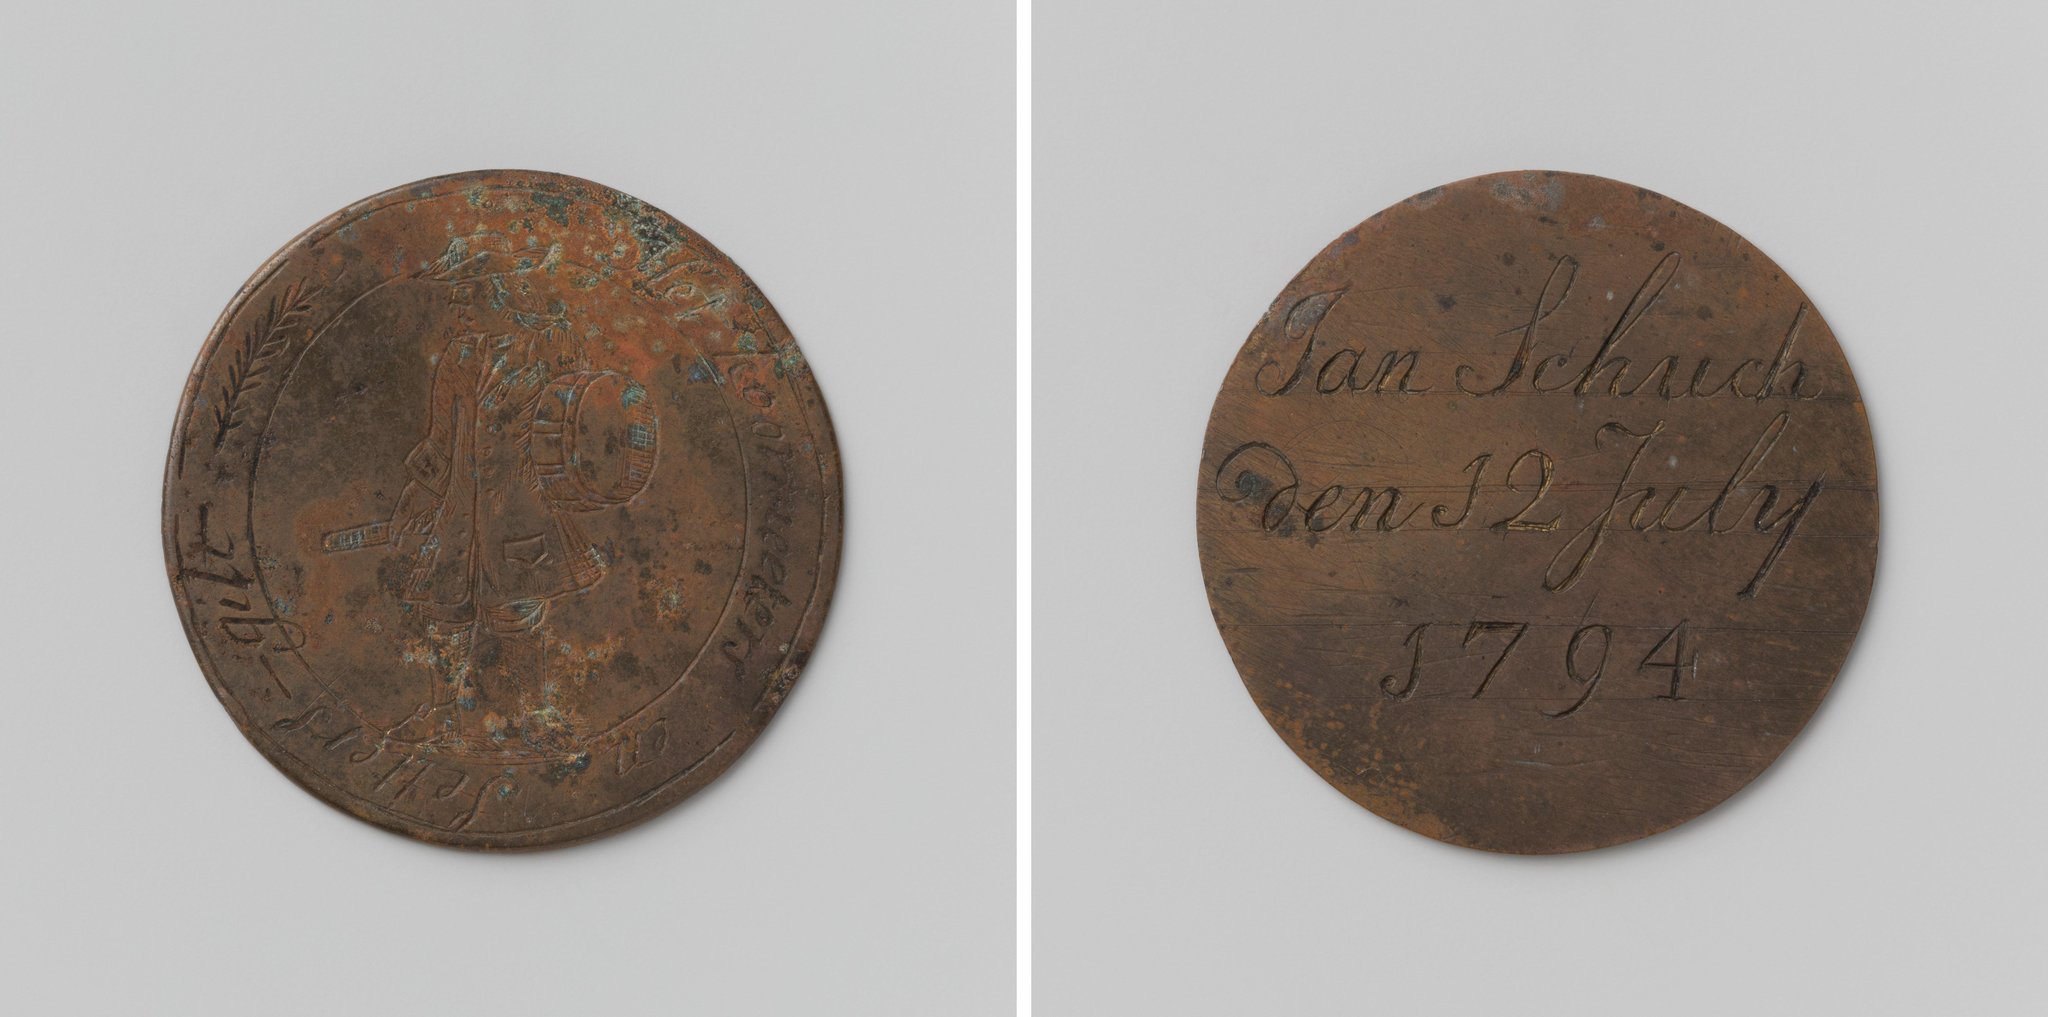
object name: medal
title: Korenmeters- en -zettersgilde van Amsterdam, gildepenning van Jan Schuch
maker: Anonymous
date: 1794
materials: brass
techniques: engraving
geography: amsterdam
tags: amsterdam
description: Messing penning. Voorzijde: naar links gewende man met hoed op hoofd, strijkstok in rechter- en korenmaat in linkerhand binnen omschrift. Keerzijde: opschrift